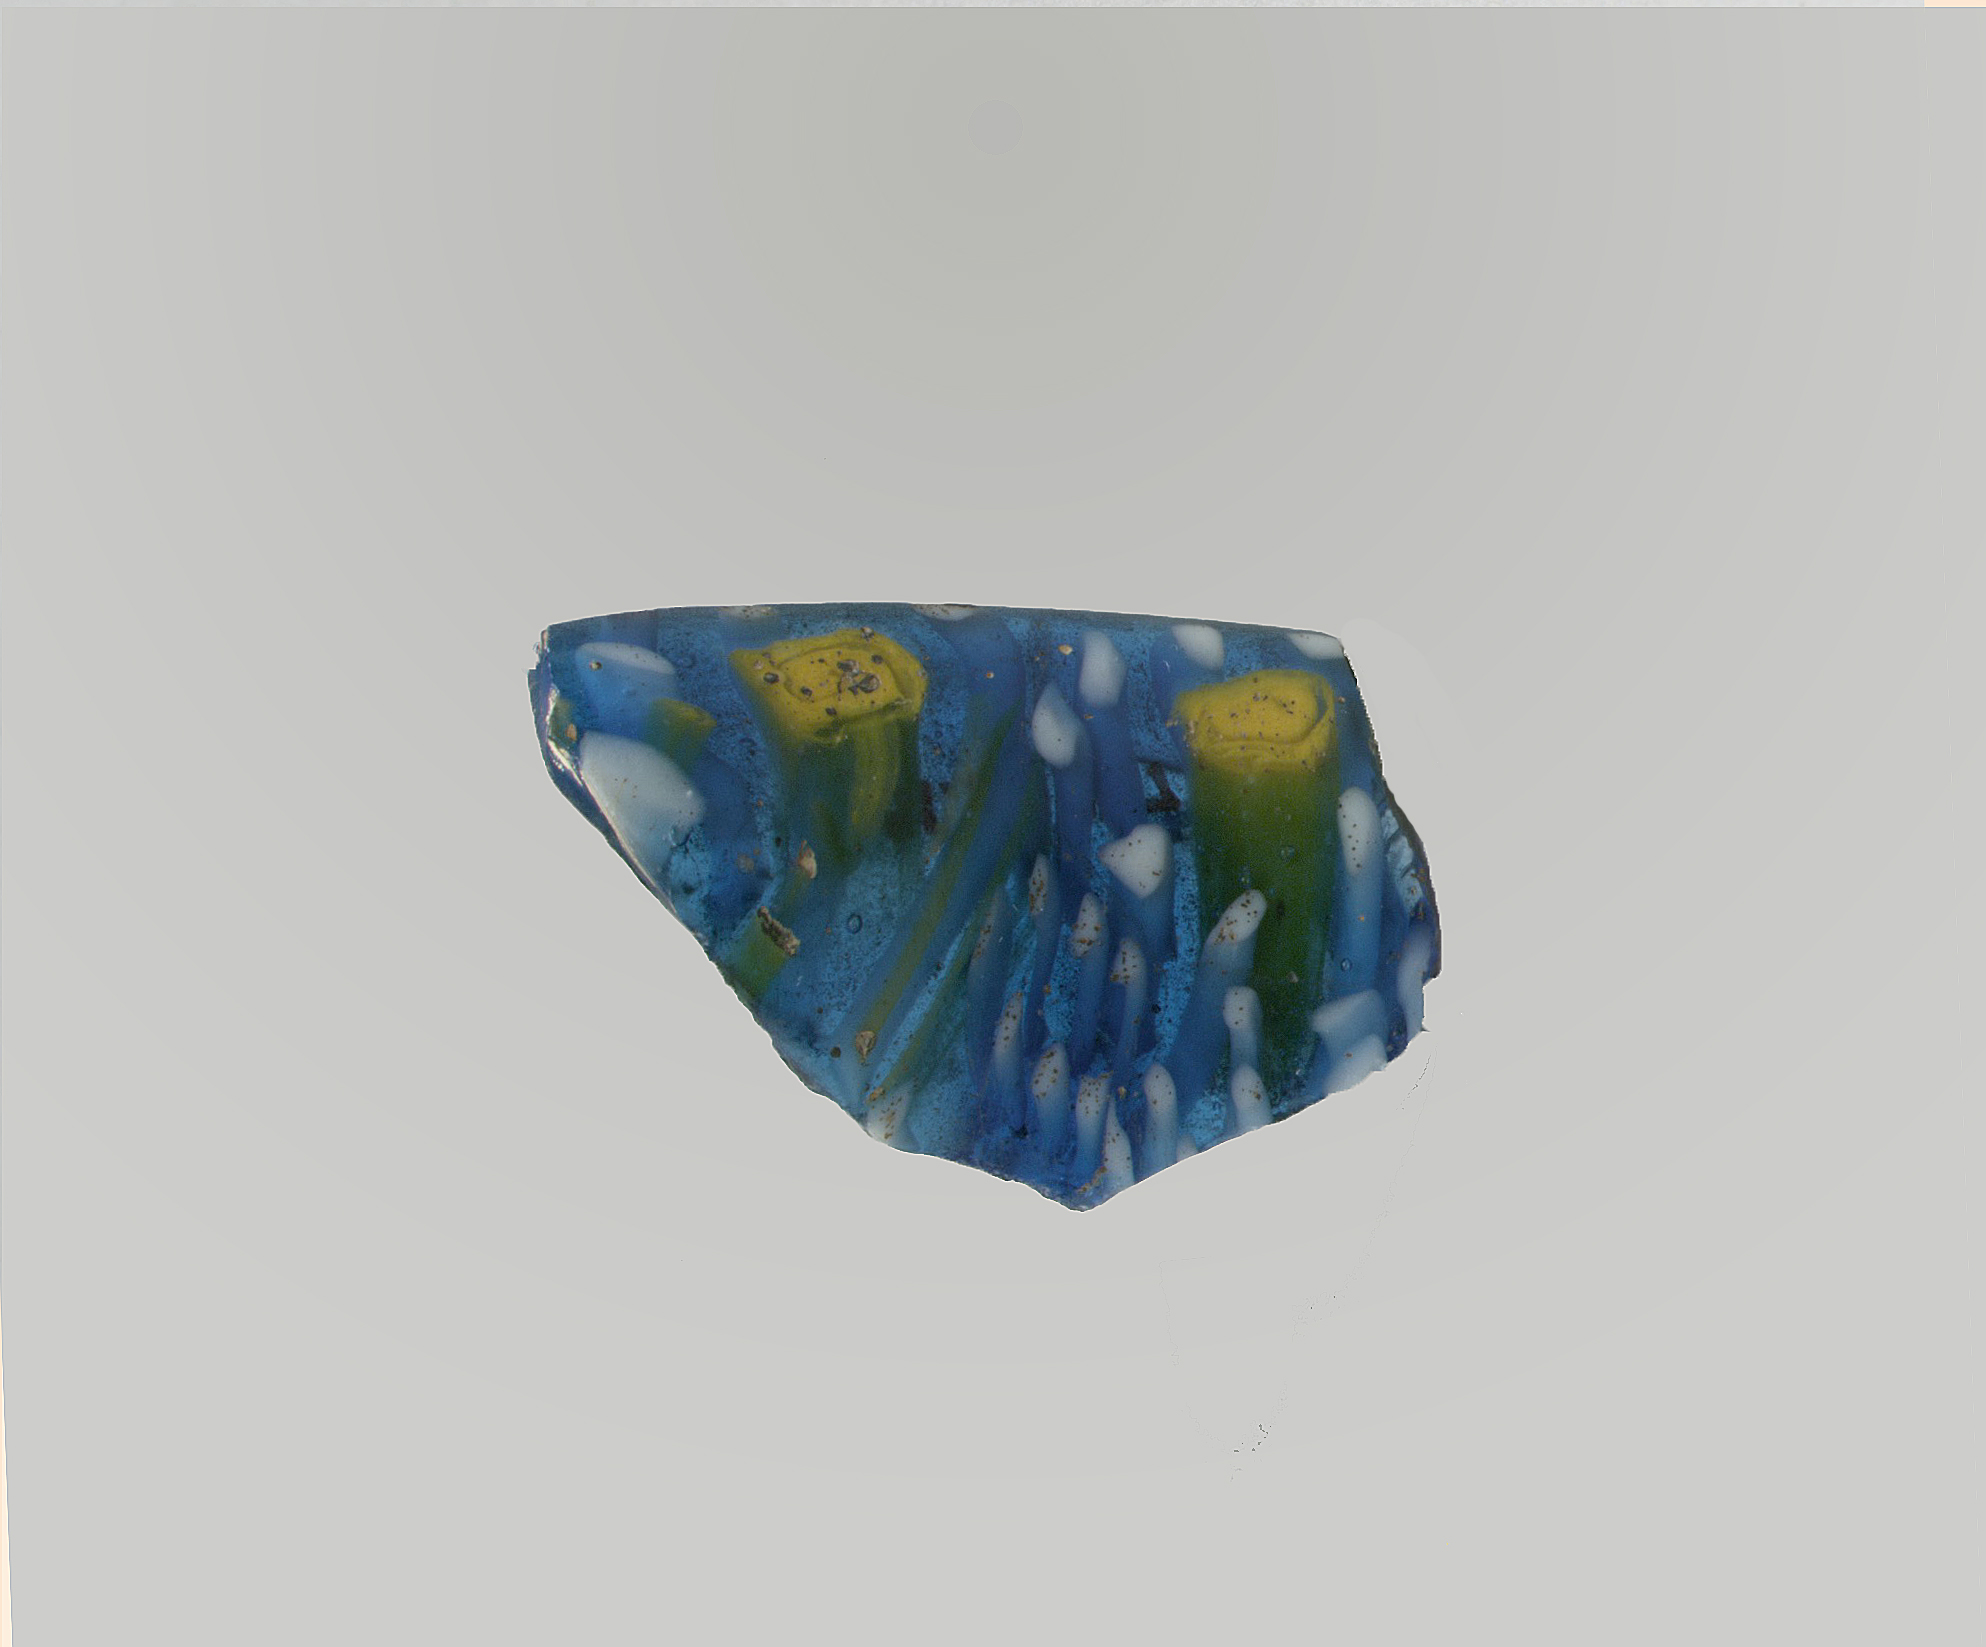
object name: fragment, ribbed bowl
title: Glass mosaic ribbed bowl fragment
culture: roman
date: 34 BCE-33 CE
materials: glass